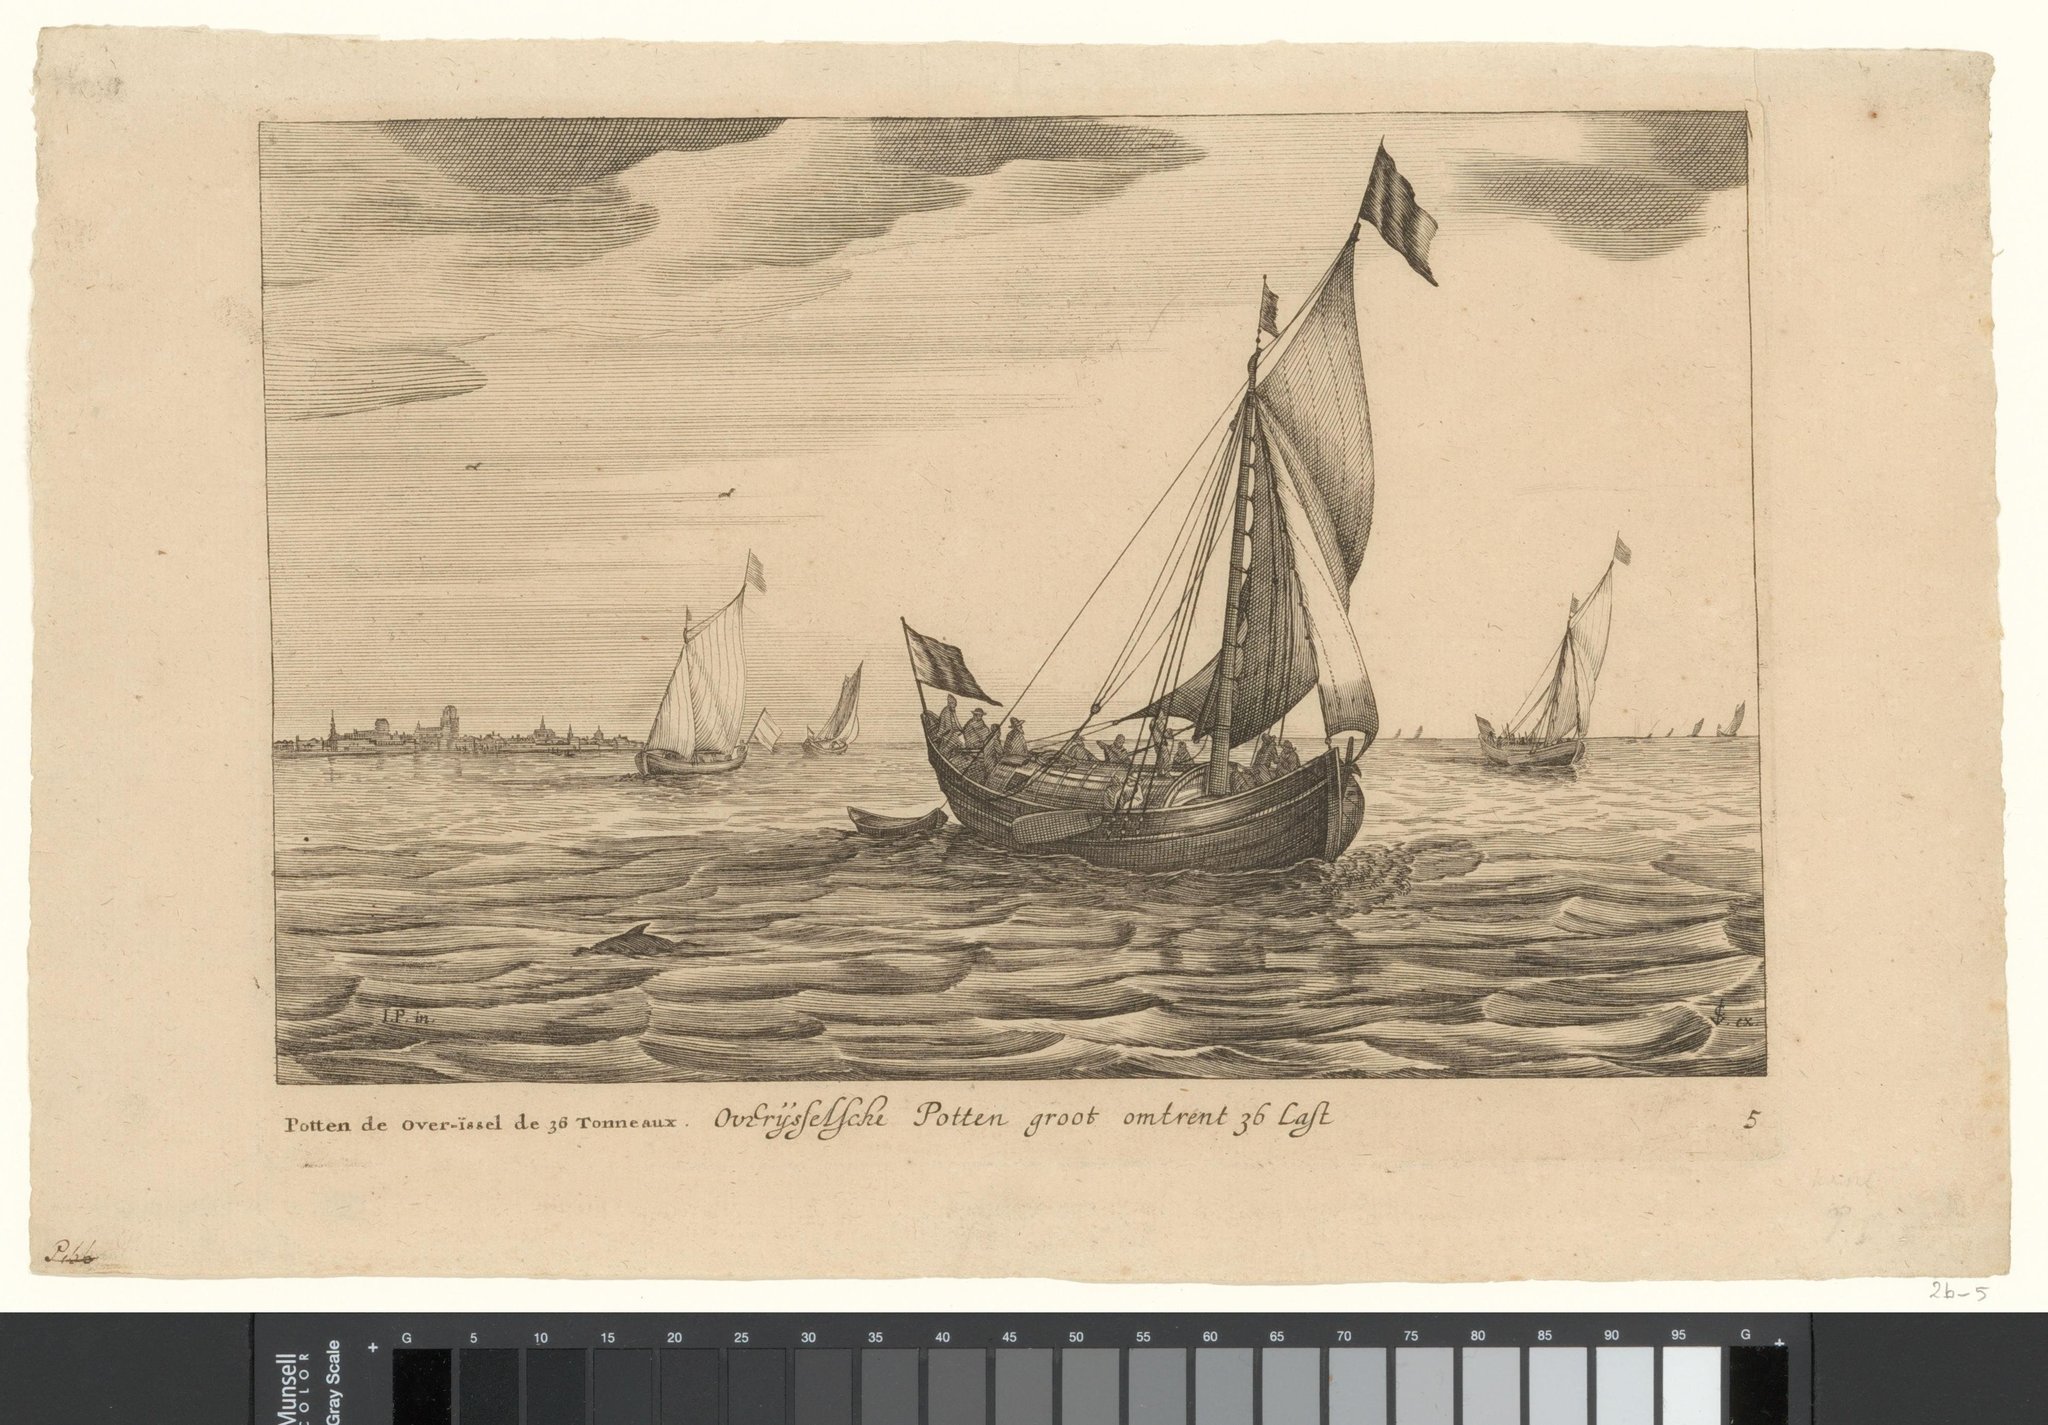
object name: print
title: Overijsselse potten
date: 1717-1779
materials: paper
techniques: engraving, etching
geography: haarlem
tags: sailing-ship, sailing-boat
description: Overijsselse potten op het water. Rechtsonder genummerd: 5. Onderwerpsrubrieken binnen de Atlas Zeden en Gewoonten: Handel, Nijverheid en Verkeer, Scheepsvaart.